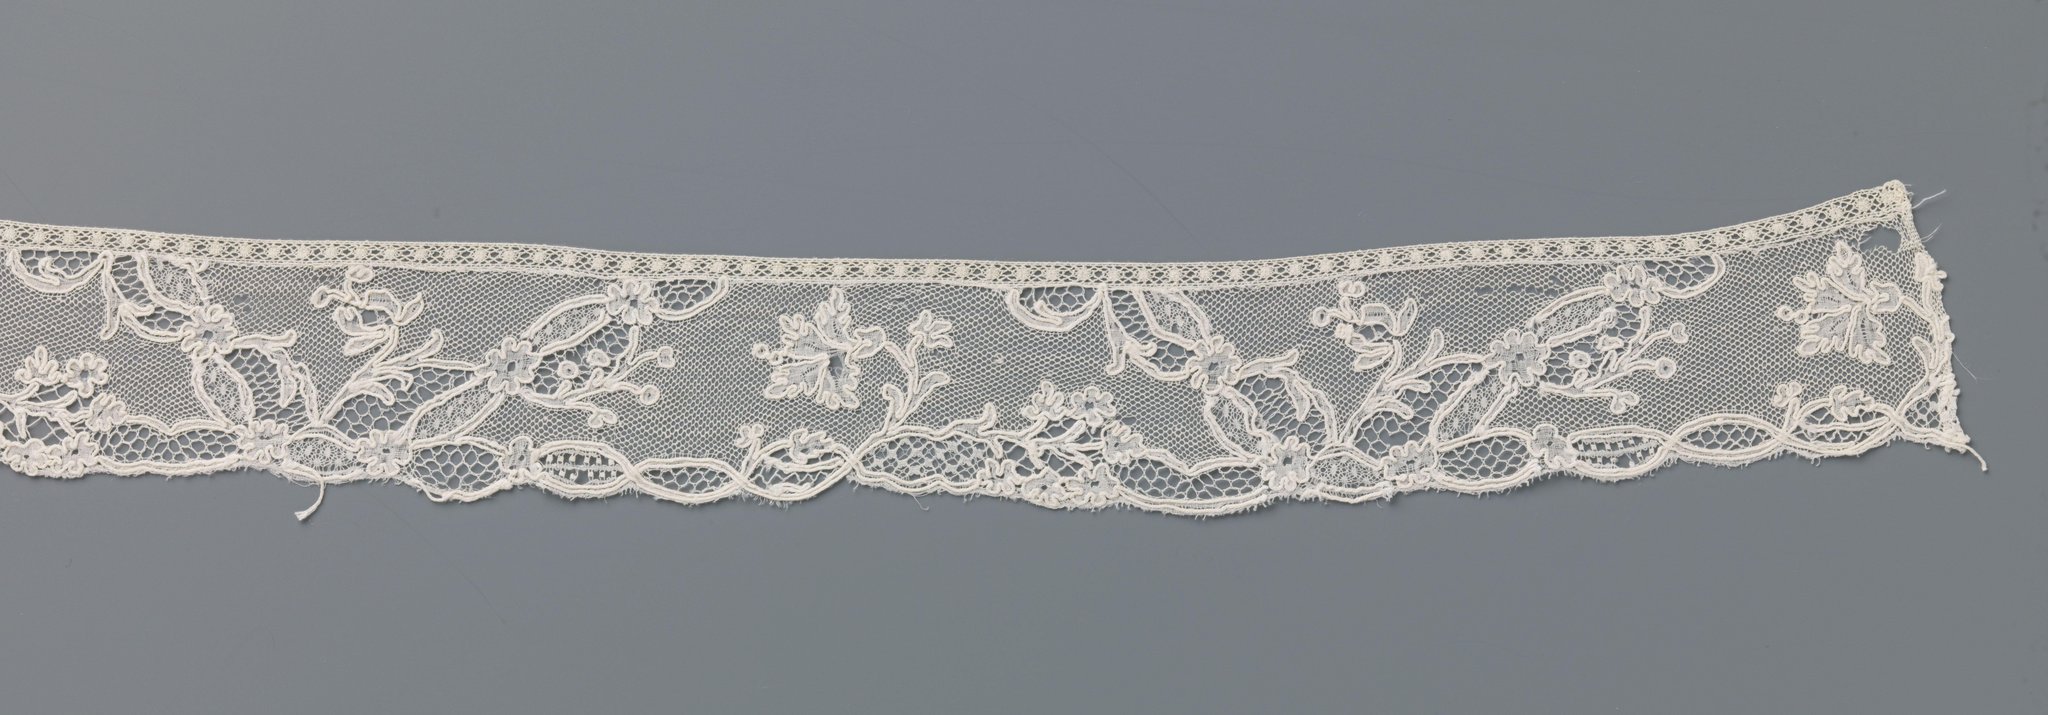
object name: strip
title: Strook kloskant met anjer tussen v-vormige velden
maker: Anonymous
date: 1780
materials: linen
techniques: lace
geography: southern netherlands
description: Strook naturelkleurige kloskant: Mechelse kant. Het patroon bestaat uit een dubbele smalle slinger, die langs de onderzijde een aaneenschakeling van spitsovaalvormige cartouches vormt en vormt tevens op regelmatige afstand met schuine lijnen naar de bovenkant van de strook v-vormige velden. Een grote anjer aan een gebogen steel ontspringt uit de slinger langs de onderrand en staat steeds in de ruimte tussen twee opeenvolgende v-vormige velden. De motieven zijn met elkaar verbonden door een fijne maasgrond. De motieven zijn gemaakt in linnenslag met zeer dikke contourdraden. Er zijn verschillende siergronden toegepast in de cartouches en in restruimtes. De flauw geschulpte onderzijde komt voort uit het patroon met de dubbele slinger en is afgewerkt met picots. De bovenzijde is afgewerkt met een apart geklost recht bandje.